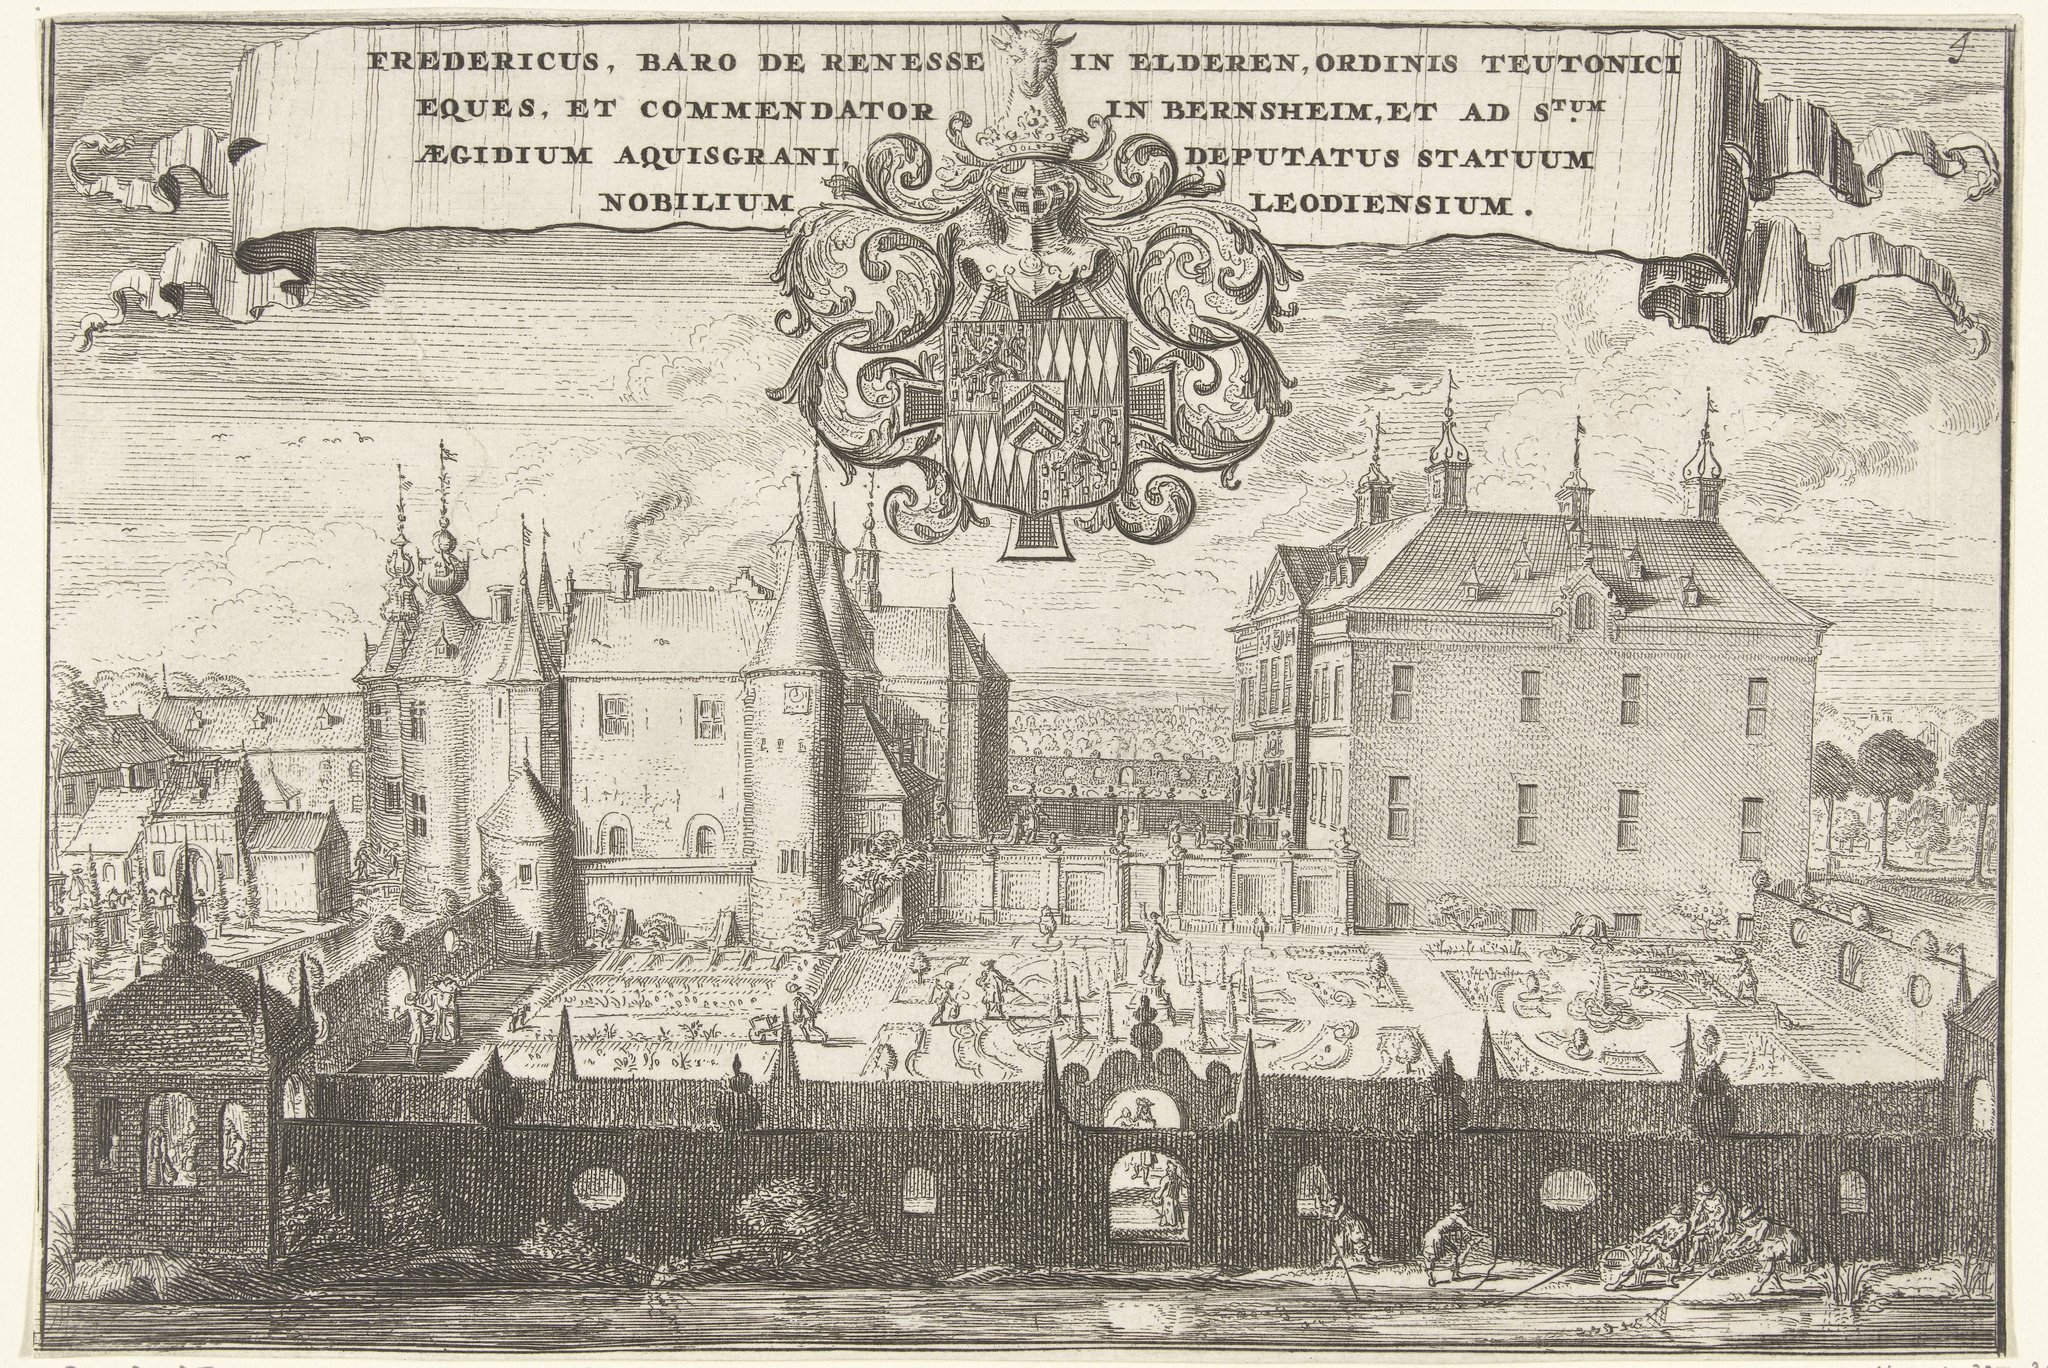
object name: print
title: Gezicht op kasteel Bernissem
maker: romeyn de hooghe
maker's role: draughtsman, goldsmith, painter, print maker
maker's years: 1645-1708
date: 1700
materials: paper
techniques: etching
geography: haarlem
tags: castle, military orders, e.g.: knights templars, knights of malta, teutonic knights ~ roman catholic church, armorial bearing, heraldry, sint-truiden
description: Gezicht op kasteel Bernissem bij Sint-Truiden. Bovenin de voorstelling een banderol met Latijnse tekst en een wapen. Deze prent maakt deel uit van een omvangrijke voorstelling, samengesteld uit 20 afzonderlijke platen, van de geschiedenis en de werken van de Duitse Orde (midden) omgeven door voorstellingen van de landcommanderij Alden Biesen (onderaan) en de daarbij behorende commanderijen (links en rechts).